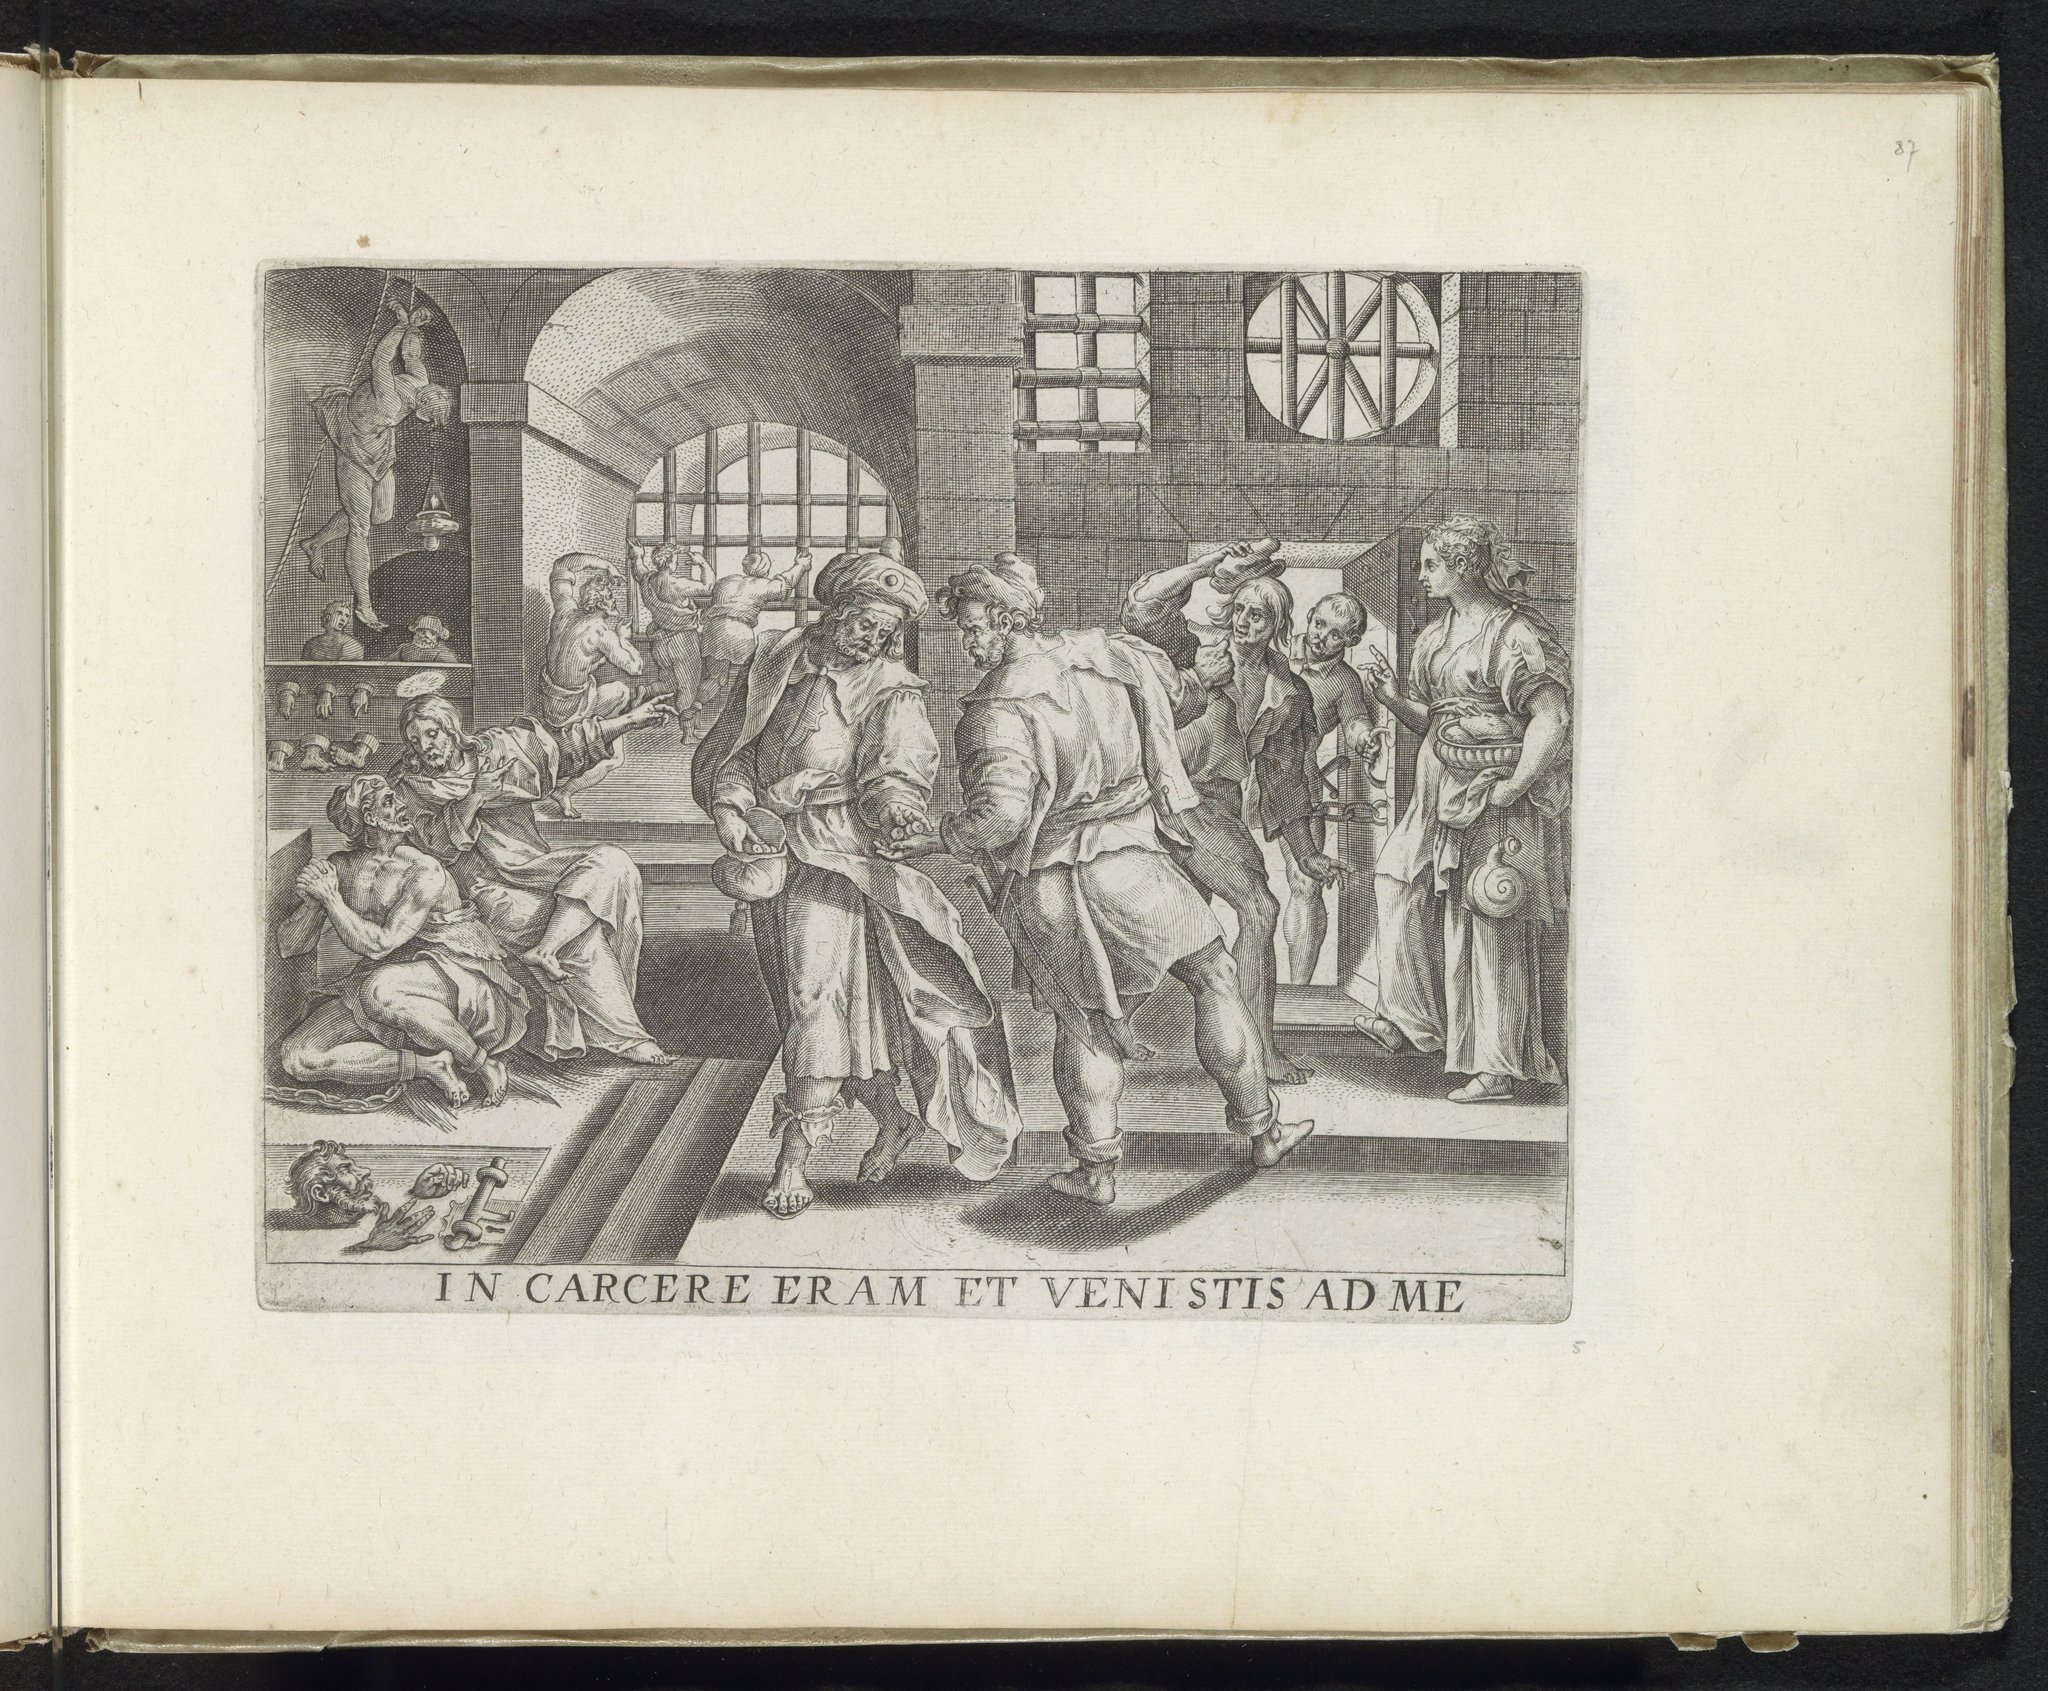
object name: album leaf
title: Thesaurus novi Testamenti elegantissimis iconibus expressus continens historias atque miracula doni nostri Iesu Christi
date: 1585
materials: paper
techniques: engraving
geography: antwerp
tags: visiting or liberating the imprisoned, 'incarceratus solatur' ~ one of the (seven) acts of mercy - vv - christ present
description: Verschillende mensen bezoeken de gevangenen in de gevangenis. Een man koopt een gevangene vrij. Een vrouw brengt voedsel. Christus spreekt links met een gevangene en wijst hem op de deur. Onder de voorstelling een verwijzing in het Latijn naar de Bijbeltekst. Deze prent maakt deel uit van een album.